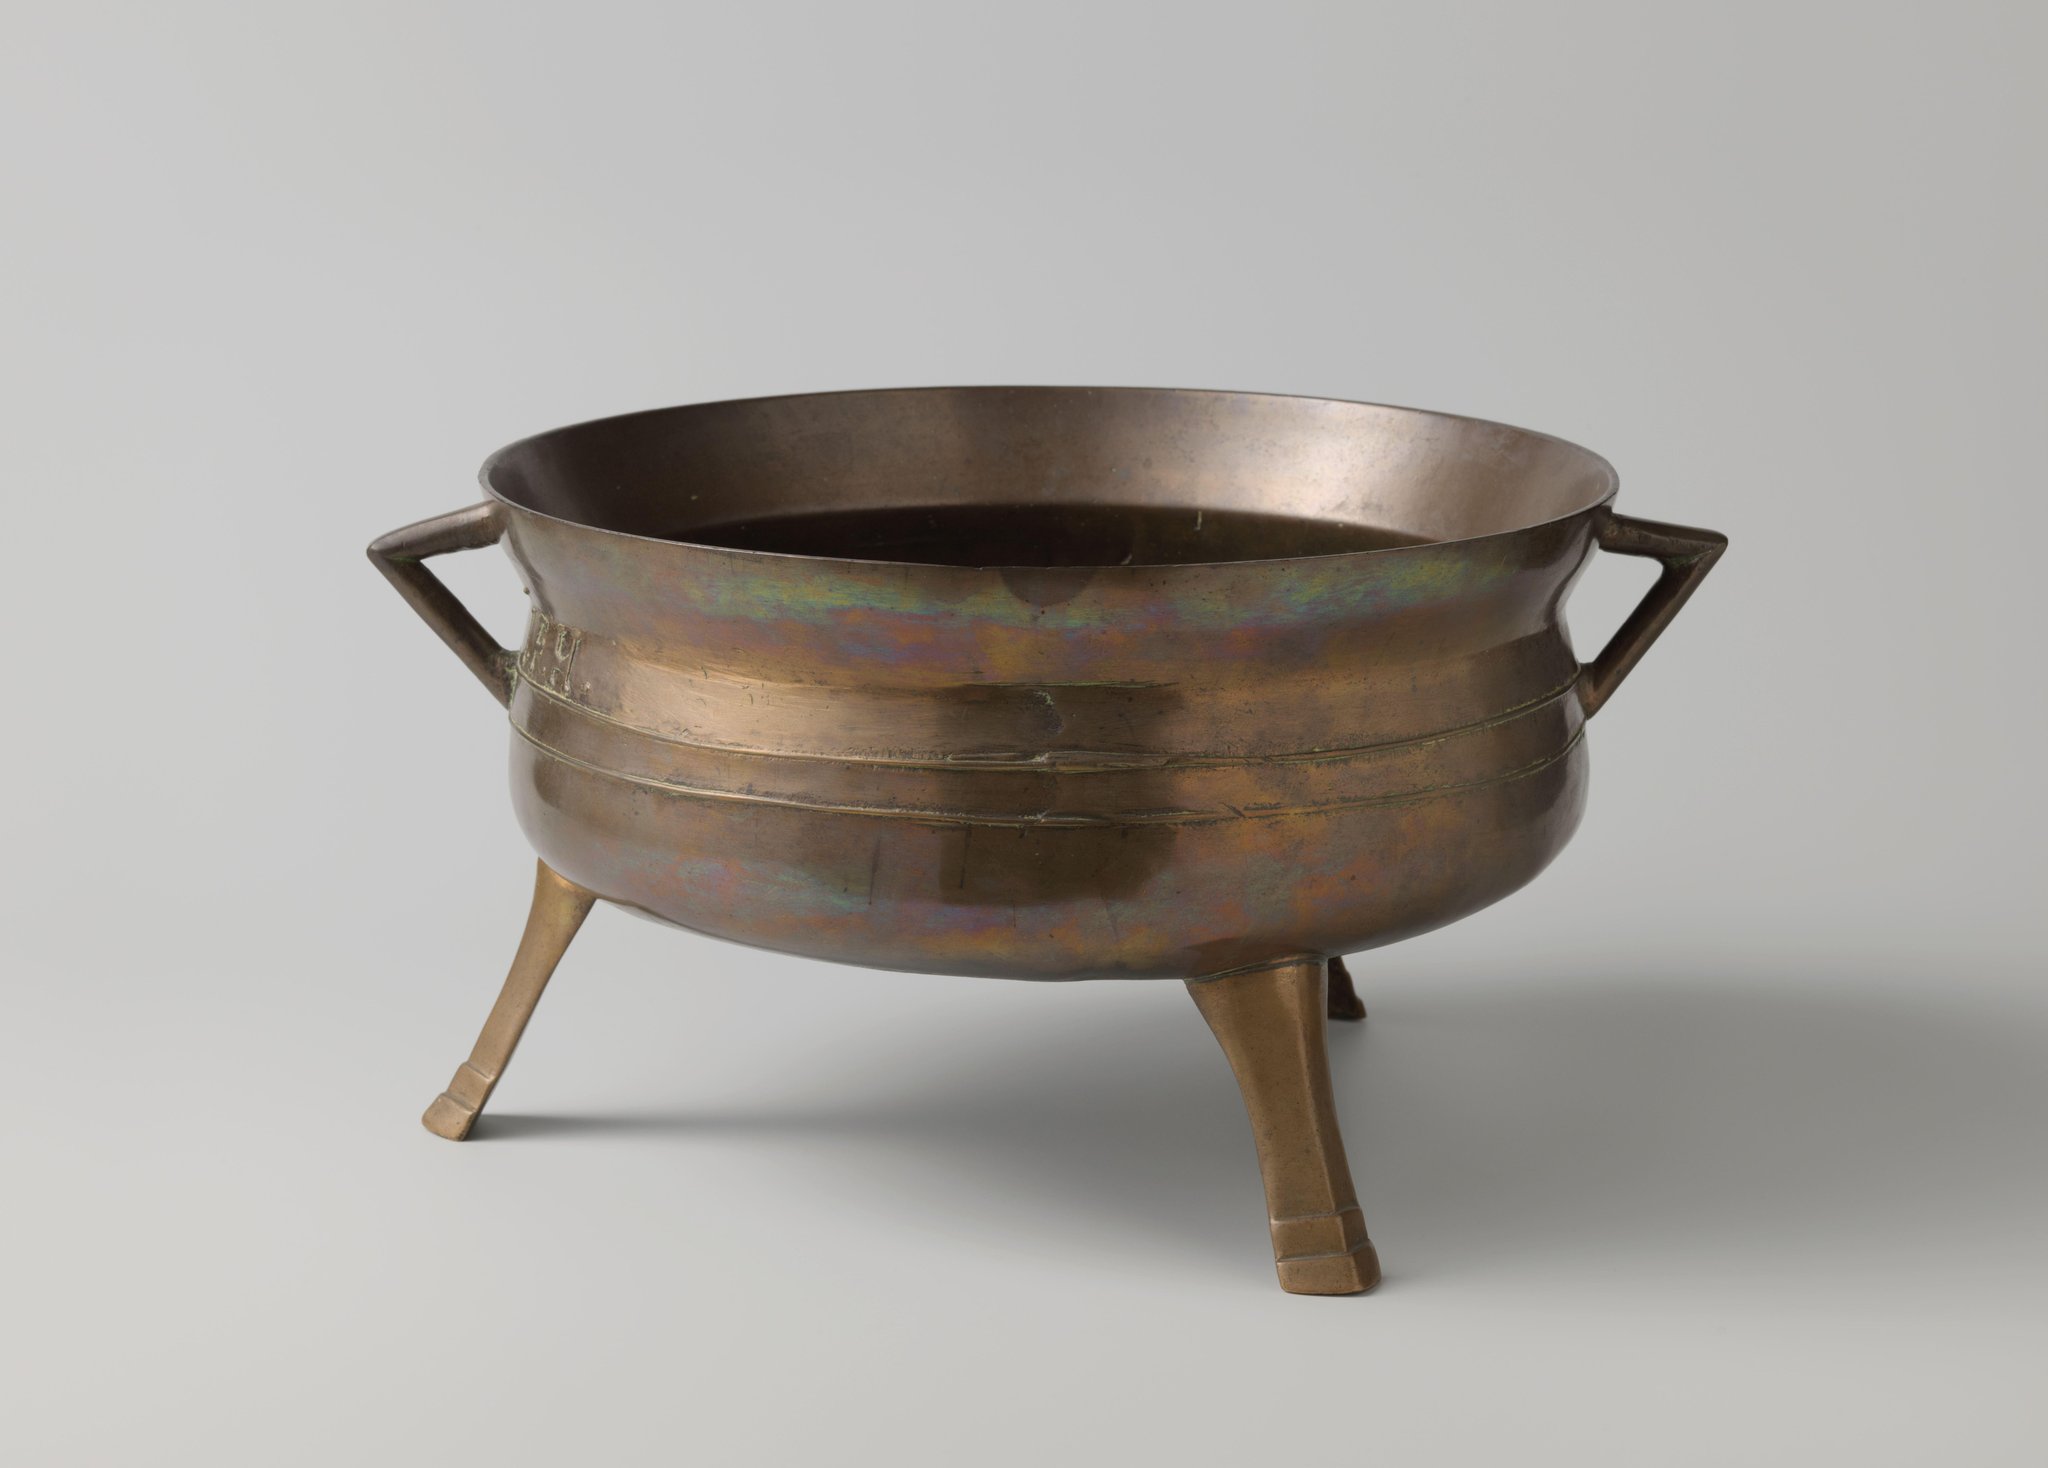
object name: cauldron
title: Kookpot van brons met gietersinitialen I.F.H.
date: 1600-1699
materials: bronze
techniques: casting, riveted, soldering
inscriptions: maker's mark: ‘I.F.H.’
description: De pot, die in zijn geheel is gegoten, heeft een gietnaad in het midden tussen de oren. De romp is rond en heeft een nagenoeg platte bodem. Hij is versierd met twee horizontale ribben met daarboven bij één oor de initialen (van de gieter) I.F.H. Romp en hals vormen een stompe hoek, die aan de binnen- en buitenkant resp. duidelijk en flauw is aangegeven. De aan de buitenzijde verdikte bovenste helft van de hals neemt de plaats in van de liprand. De pot staat op drie poten, die de doorsnede hebben van een stompe driehoek, en waarvan de voeten door twee horizontale verdikkingen zijn aangegeven. De onderkant van de romp is met een vijl ruw afgewerkt. De drie poten, die uit latere tijd stammen, zijn geklonken en gesoldeerd.